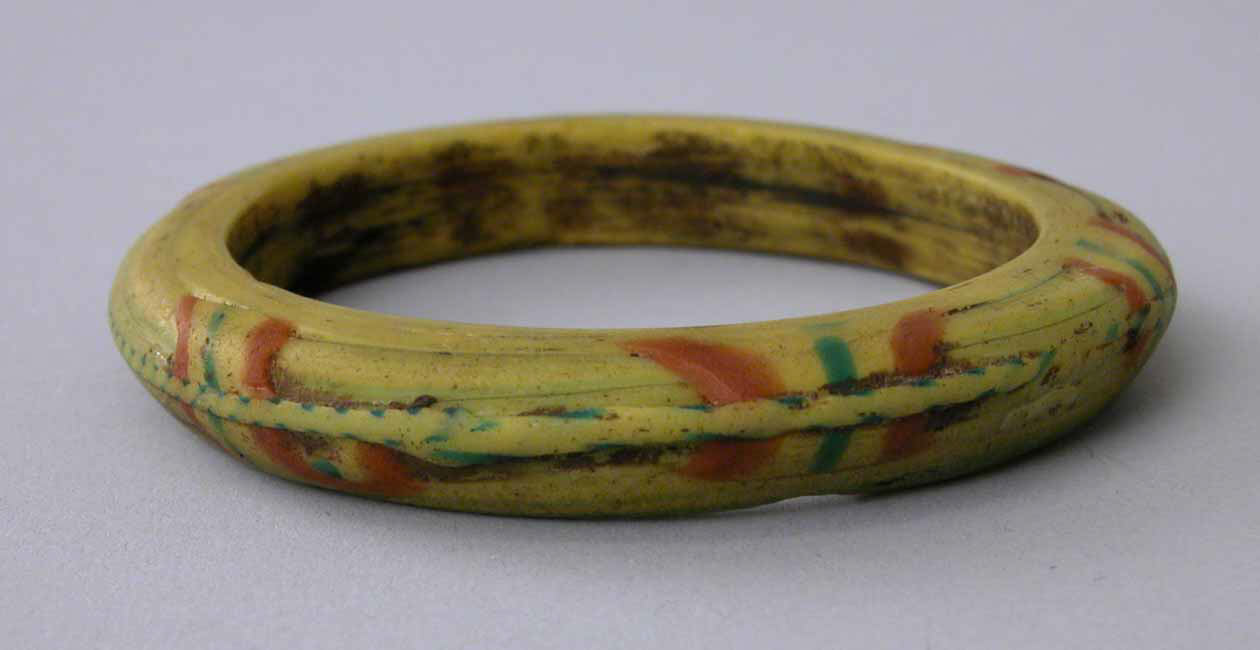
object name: bracelet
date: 1301-1500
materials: glass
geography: egypt or syria